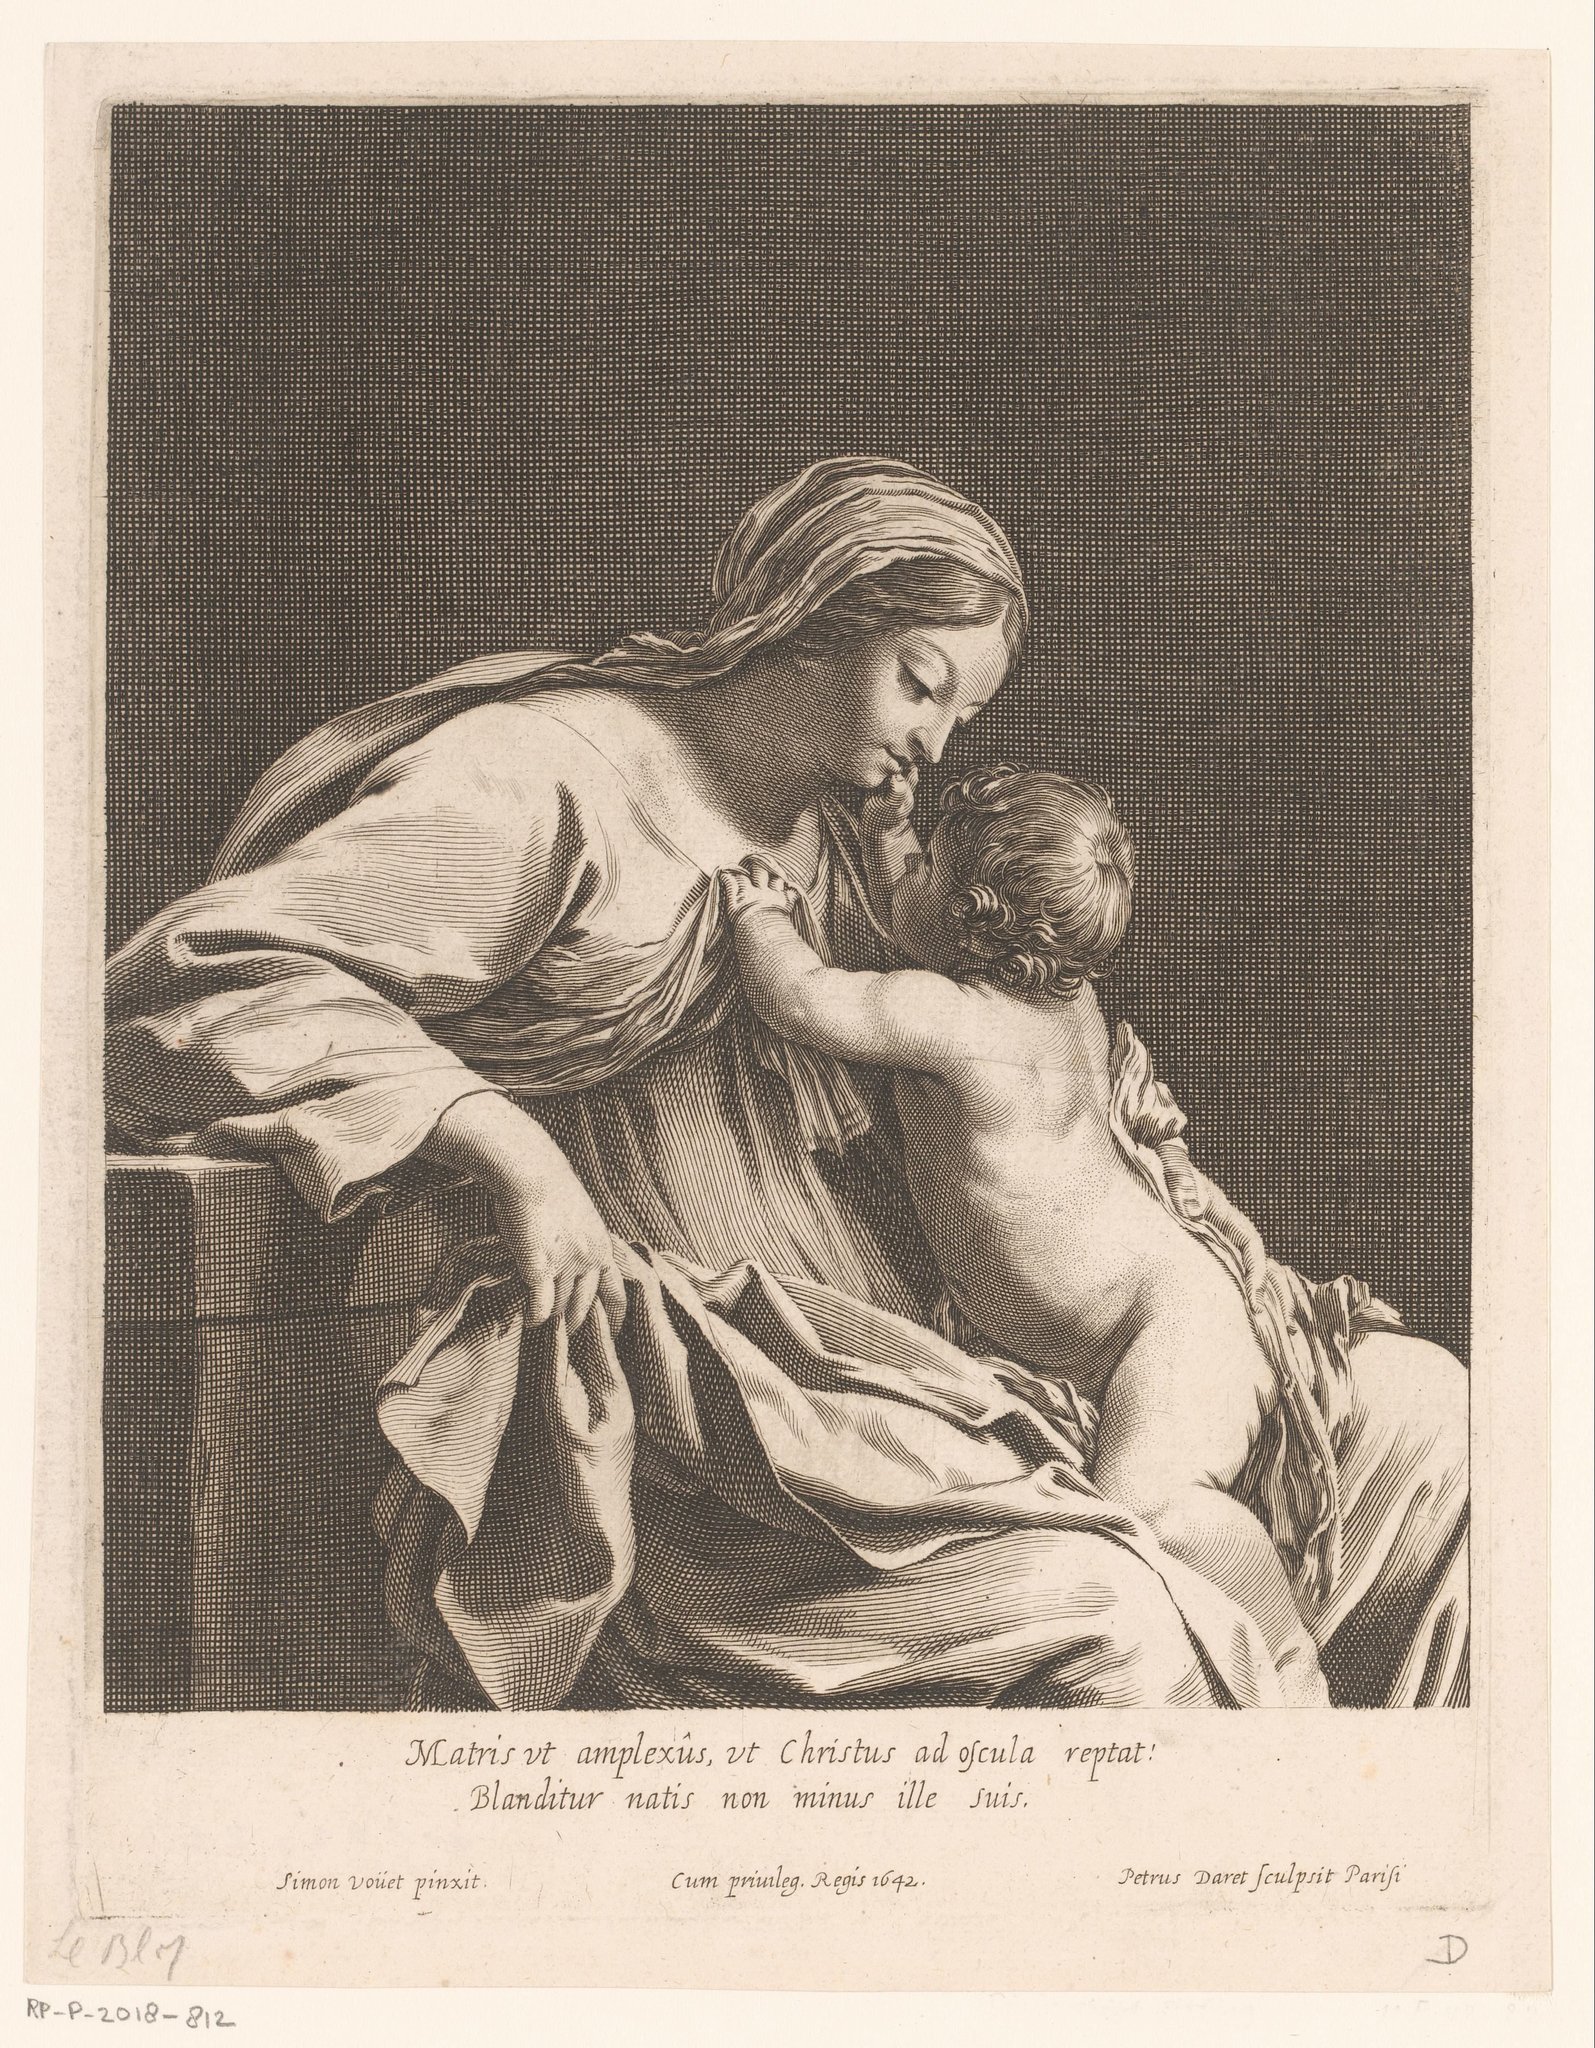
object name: print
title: Maria met Kind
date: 1642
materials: paper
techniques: engraving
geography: france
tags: madonna: i.e. mary with the christ-child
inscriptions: collector's mark: Lugt 2228